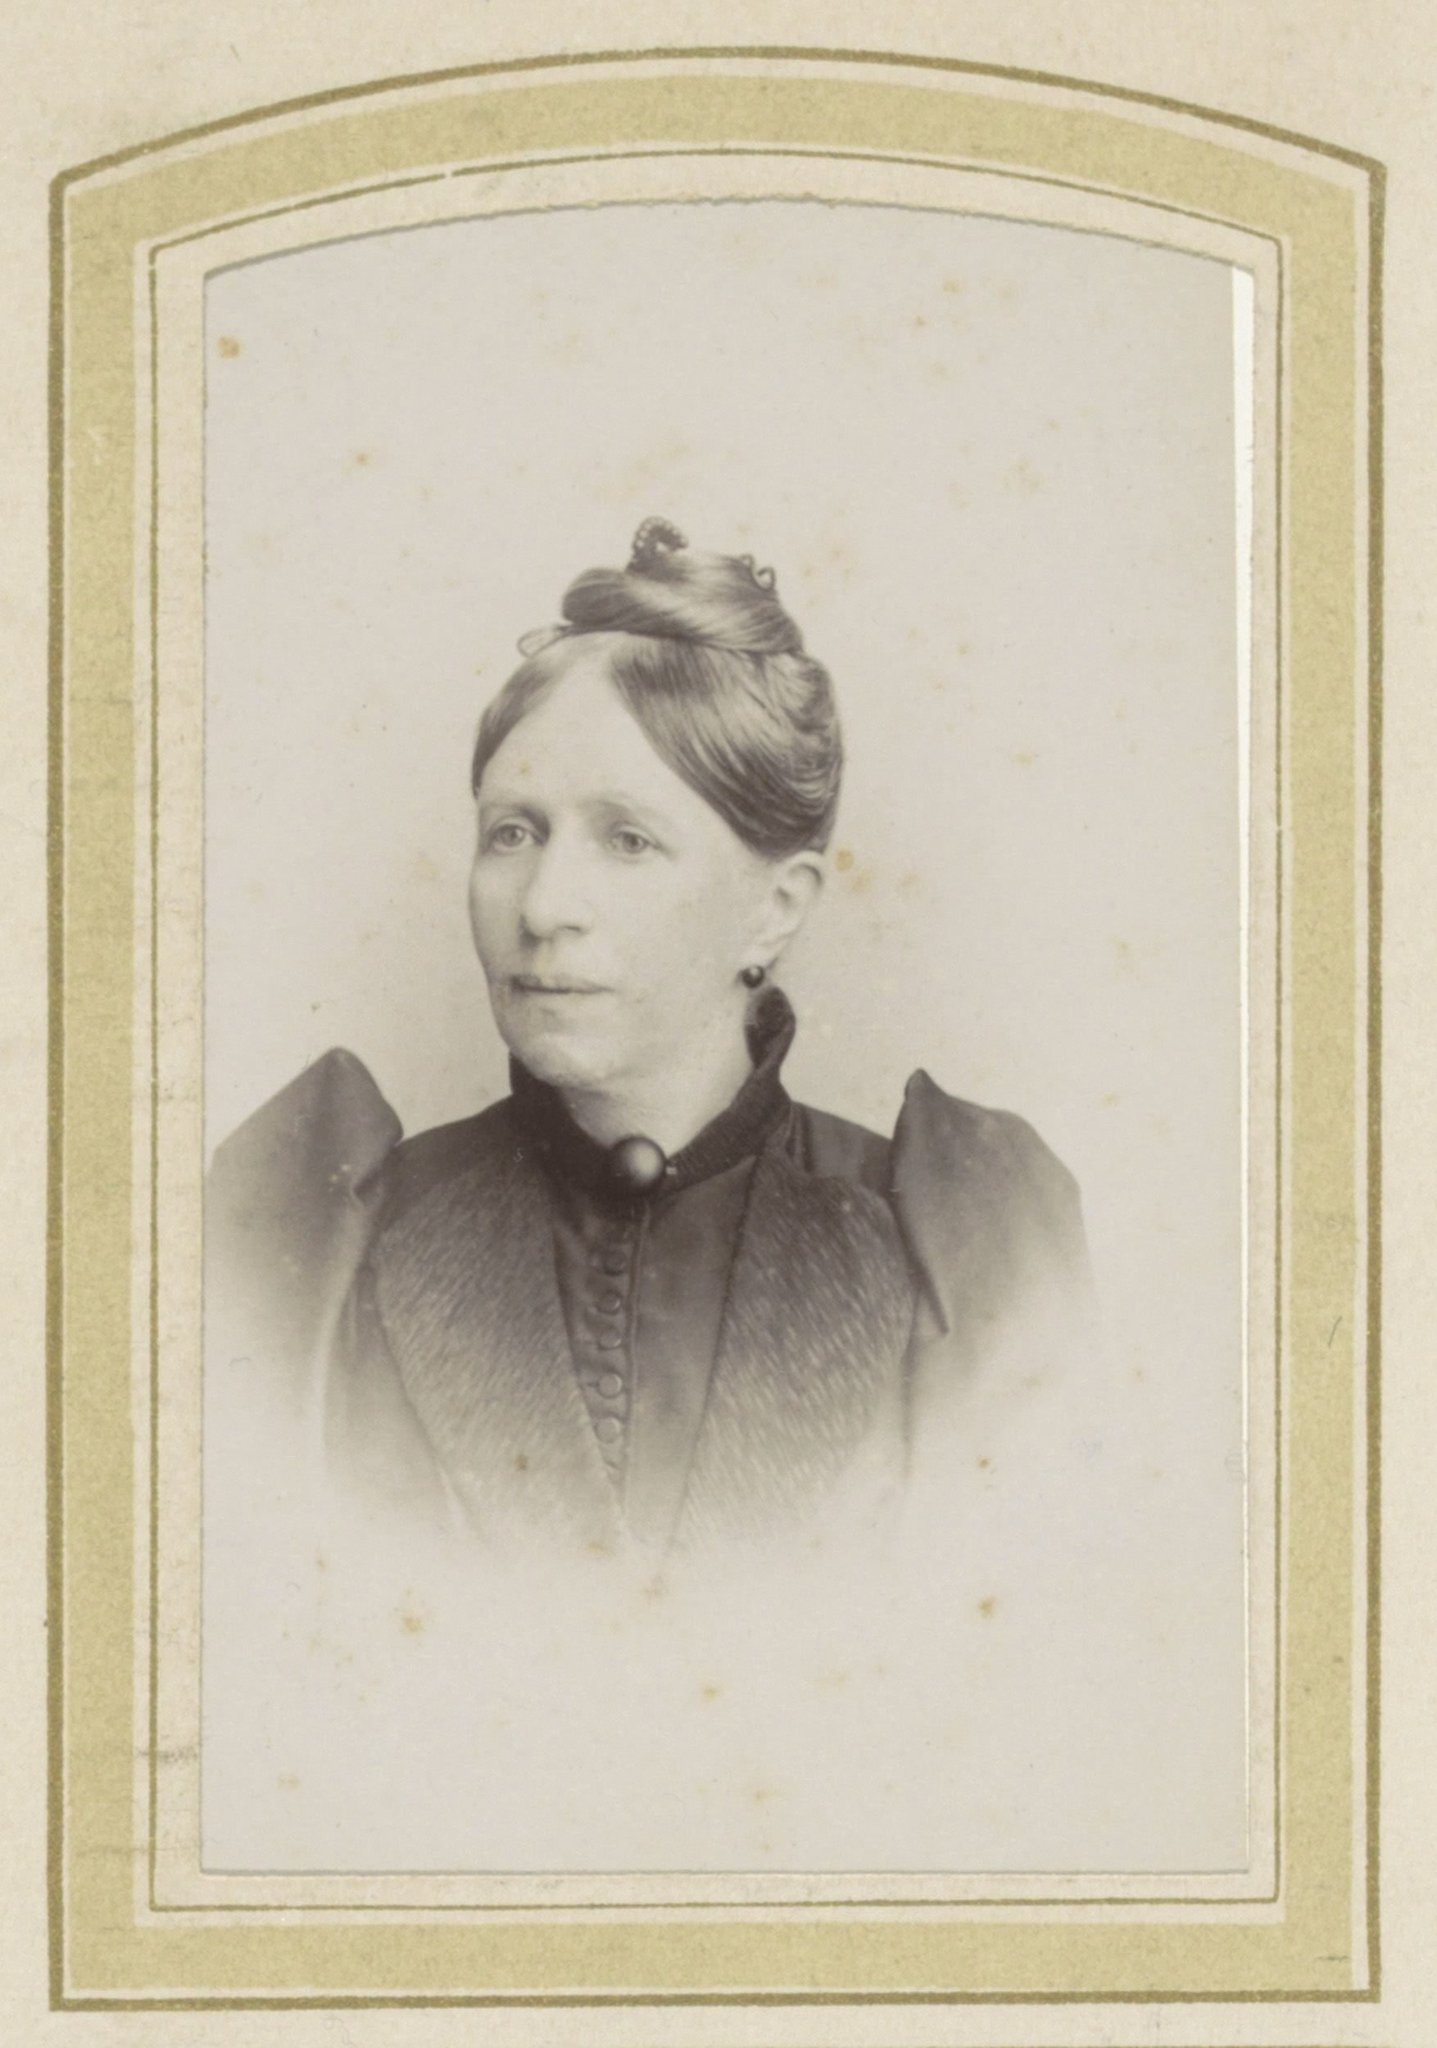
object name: photograph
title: Portret van een vrouw met een knot en een halssieraad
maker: franz reissig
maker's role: fotograaf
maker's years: 1852-1936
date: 1882-1910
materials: cardboard, paper, photographic support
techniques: albumen print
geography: breda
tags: historical persons, styles of hairdress - aa - ~ women, neck-gear ~ clothing, clothing for the upper part of the body, brooch, agraffe, clasp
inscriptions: address: ‘Breda Ginnekenstraat B 129.’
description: Onderdeel van Fotoalbum van een Nederlandse familie met 168 cartes-de-visite en kabinetfoto's.